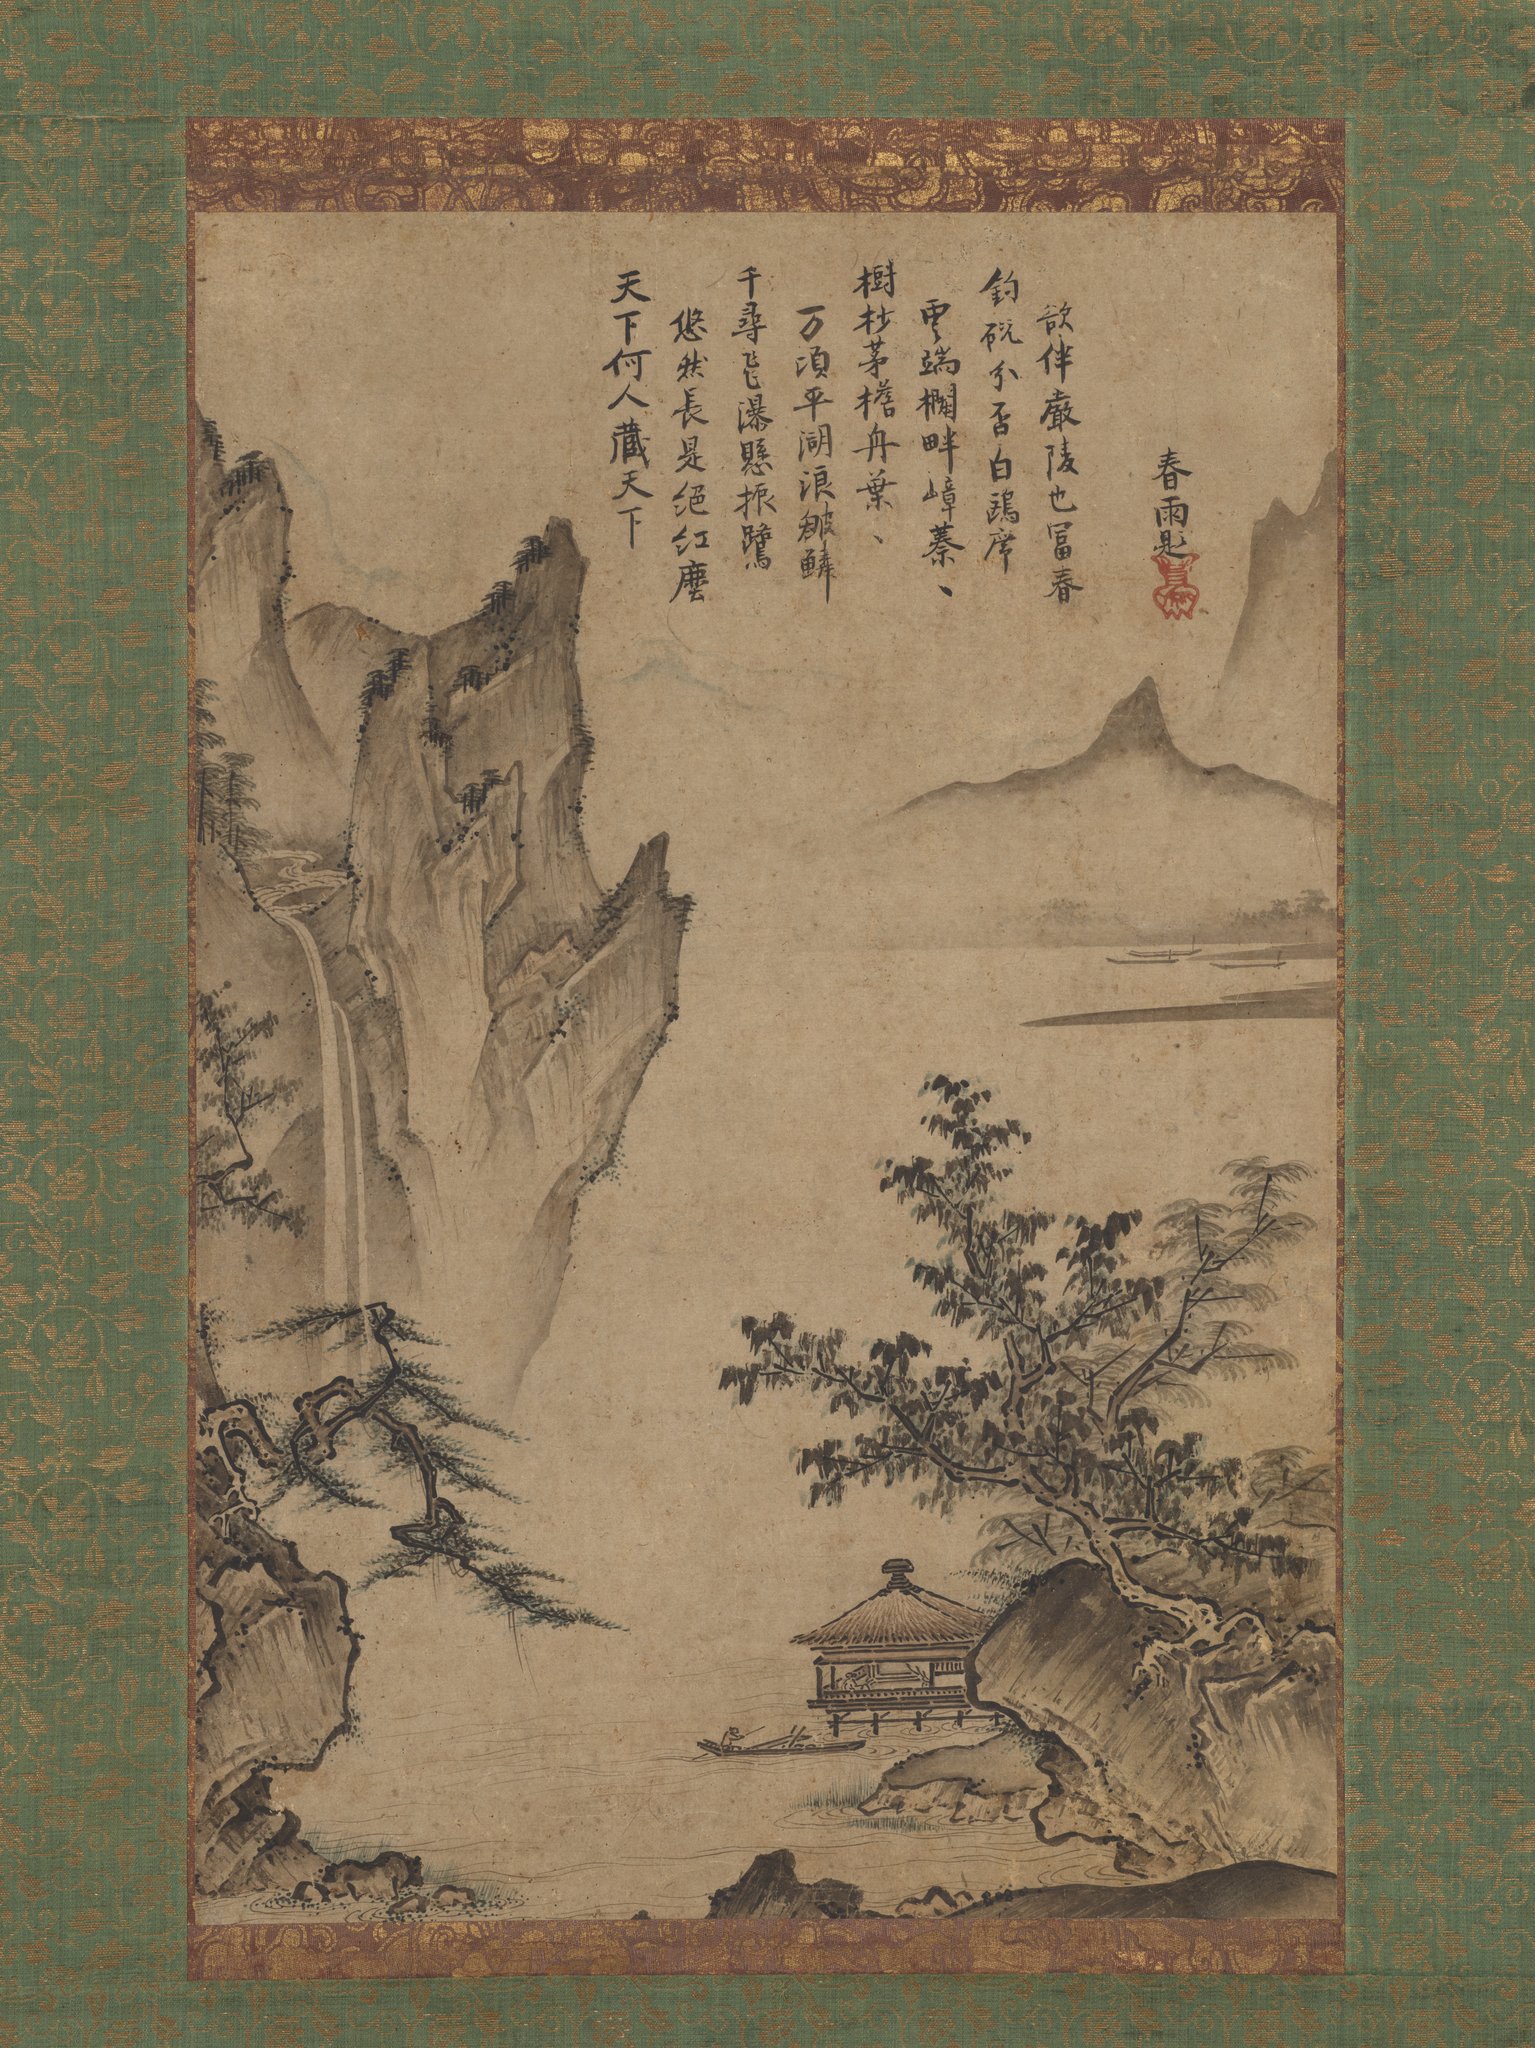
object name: hanging scroll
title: Landscape with Pavilion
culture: japanese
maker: kenkō shōkei 賢江祥啓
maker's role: artist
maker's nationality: japanese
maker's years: 1478-1523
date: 1478-1480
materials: ink, paper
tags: mountains,landscapes